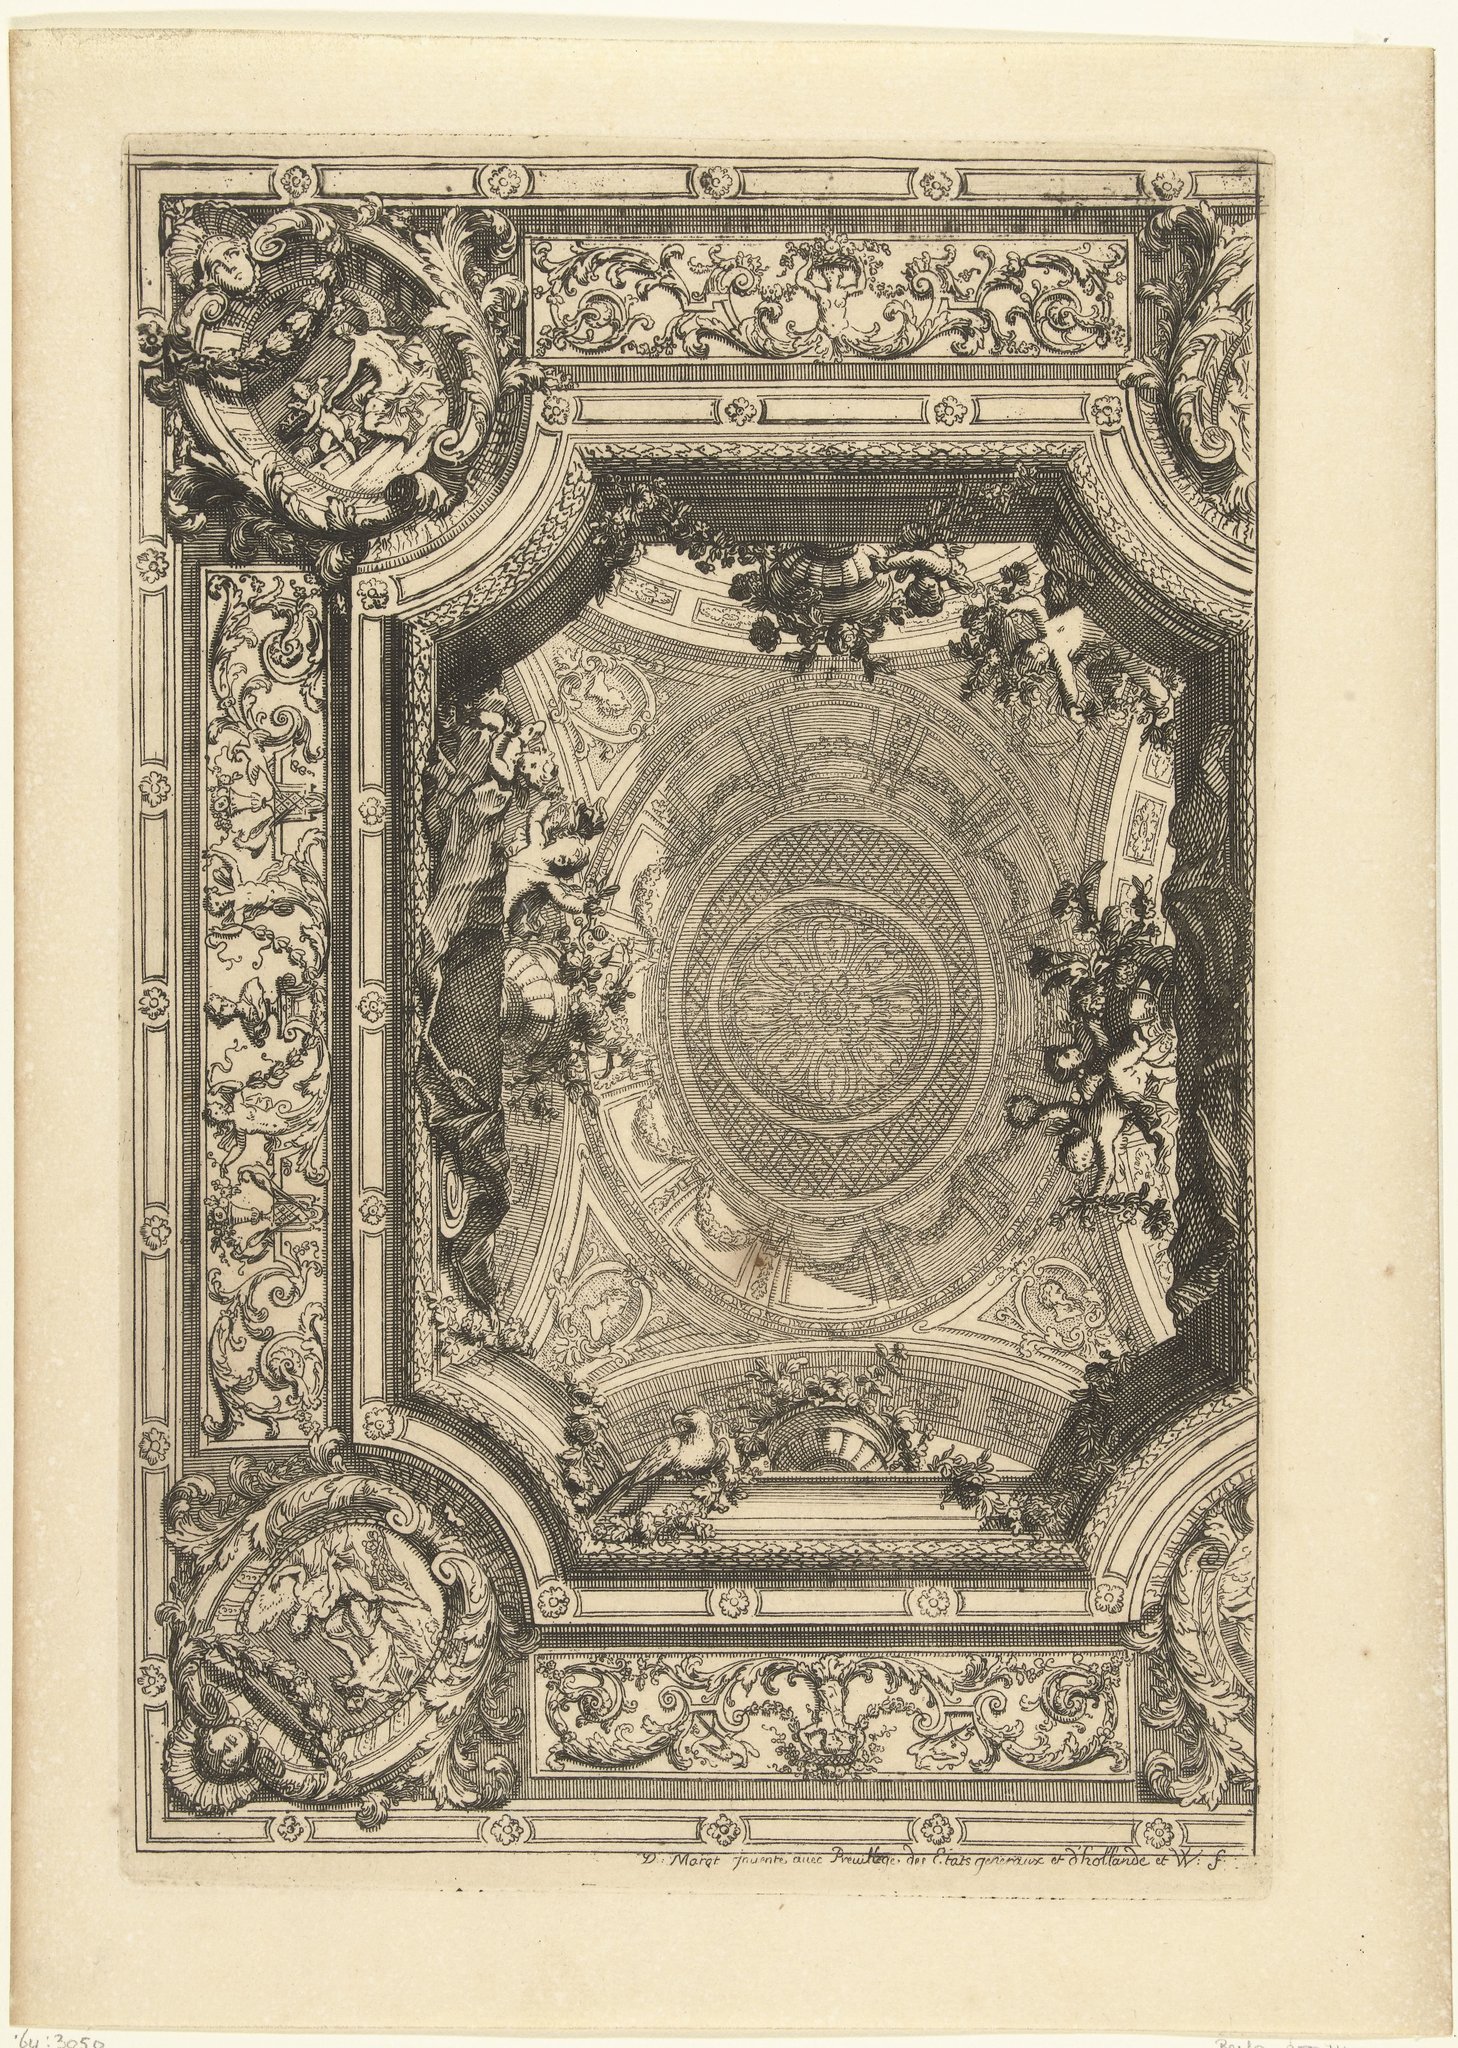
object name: ornament print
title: Plafond met trompe-l'oeil gewelf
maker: daniël marot (i)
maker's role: draughtsman, print maker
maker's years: 1661-1752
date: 1712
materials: paper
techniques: etching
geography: amsterdam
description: Het gewelf bevindt zich boven een brede randdecoratie met in de hoeken medaillons met Venus en Cupido (linksboven) en drie zittende figuren (linksonder). Uit serie van 6 bladen met ontwerpen voor plafonds.